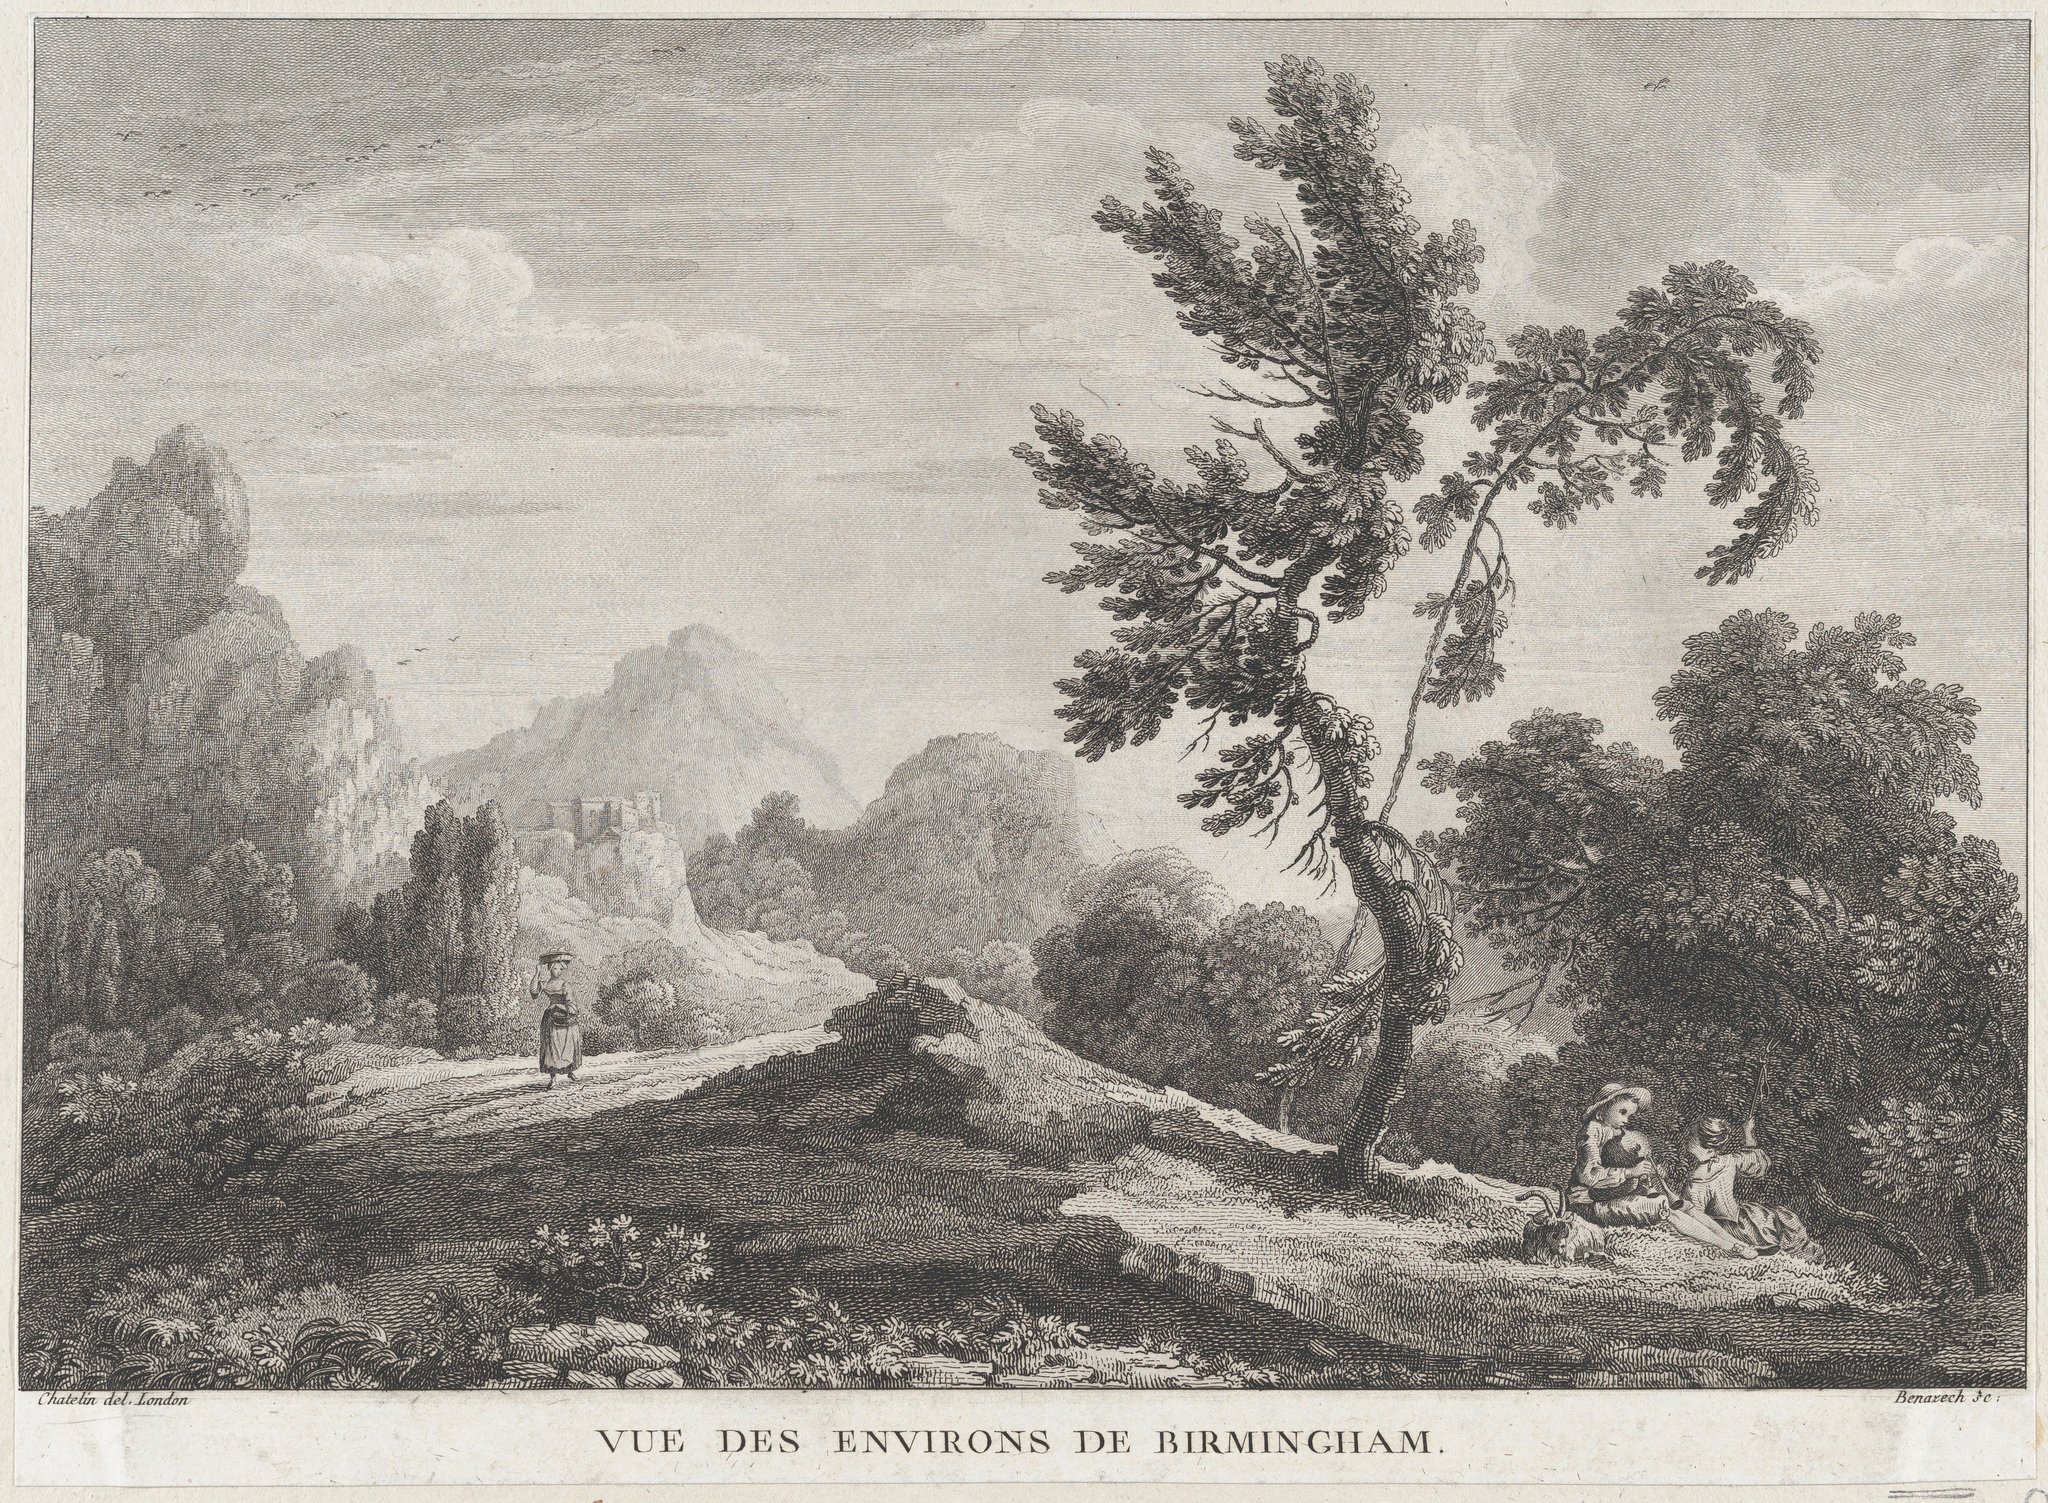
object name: print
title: View of Birmingham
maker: peter paul benazech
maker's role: engraver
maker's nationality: british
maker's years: 1730-1783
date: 1755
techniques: etching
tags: women,hills,landscapes,trees